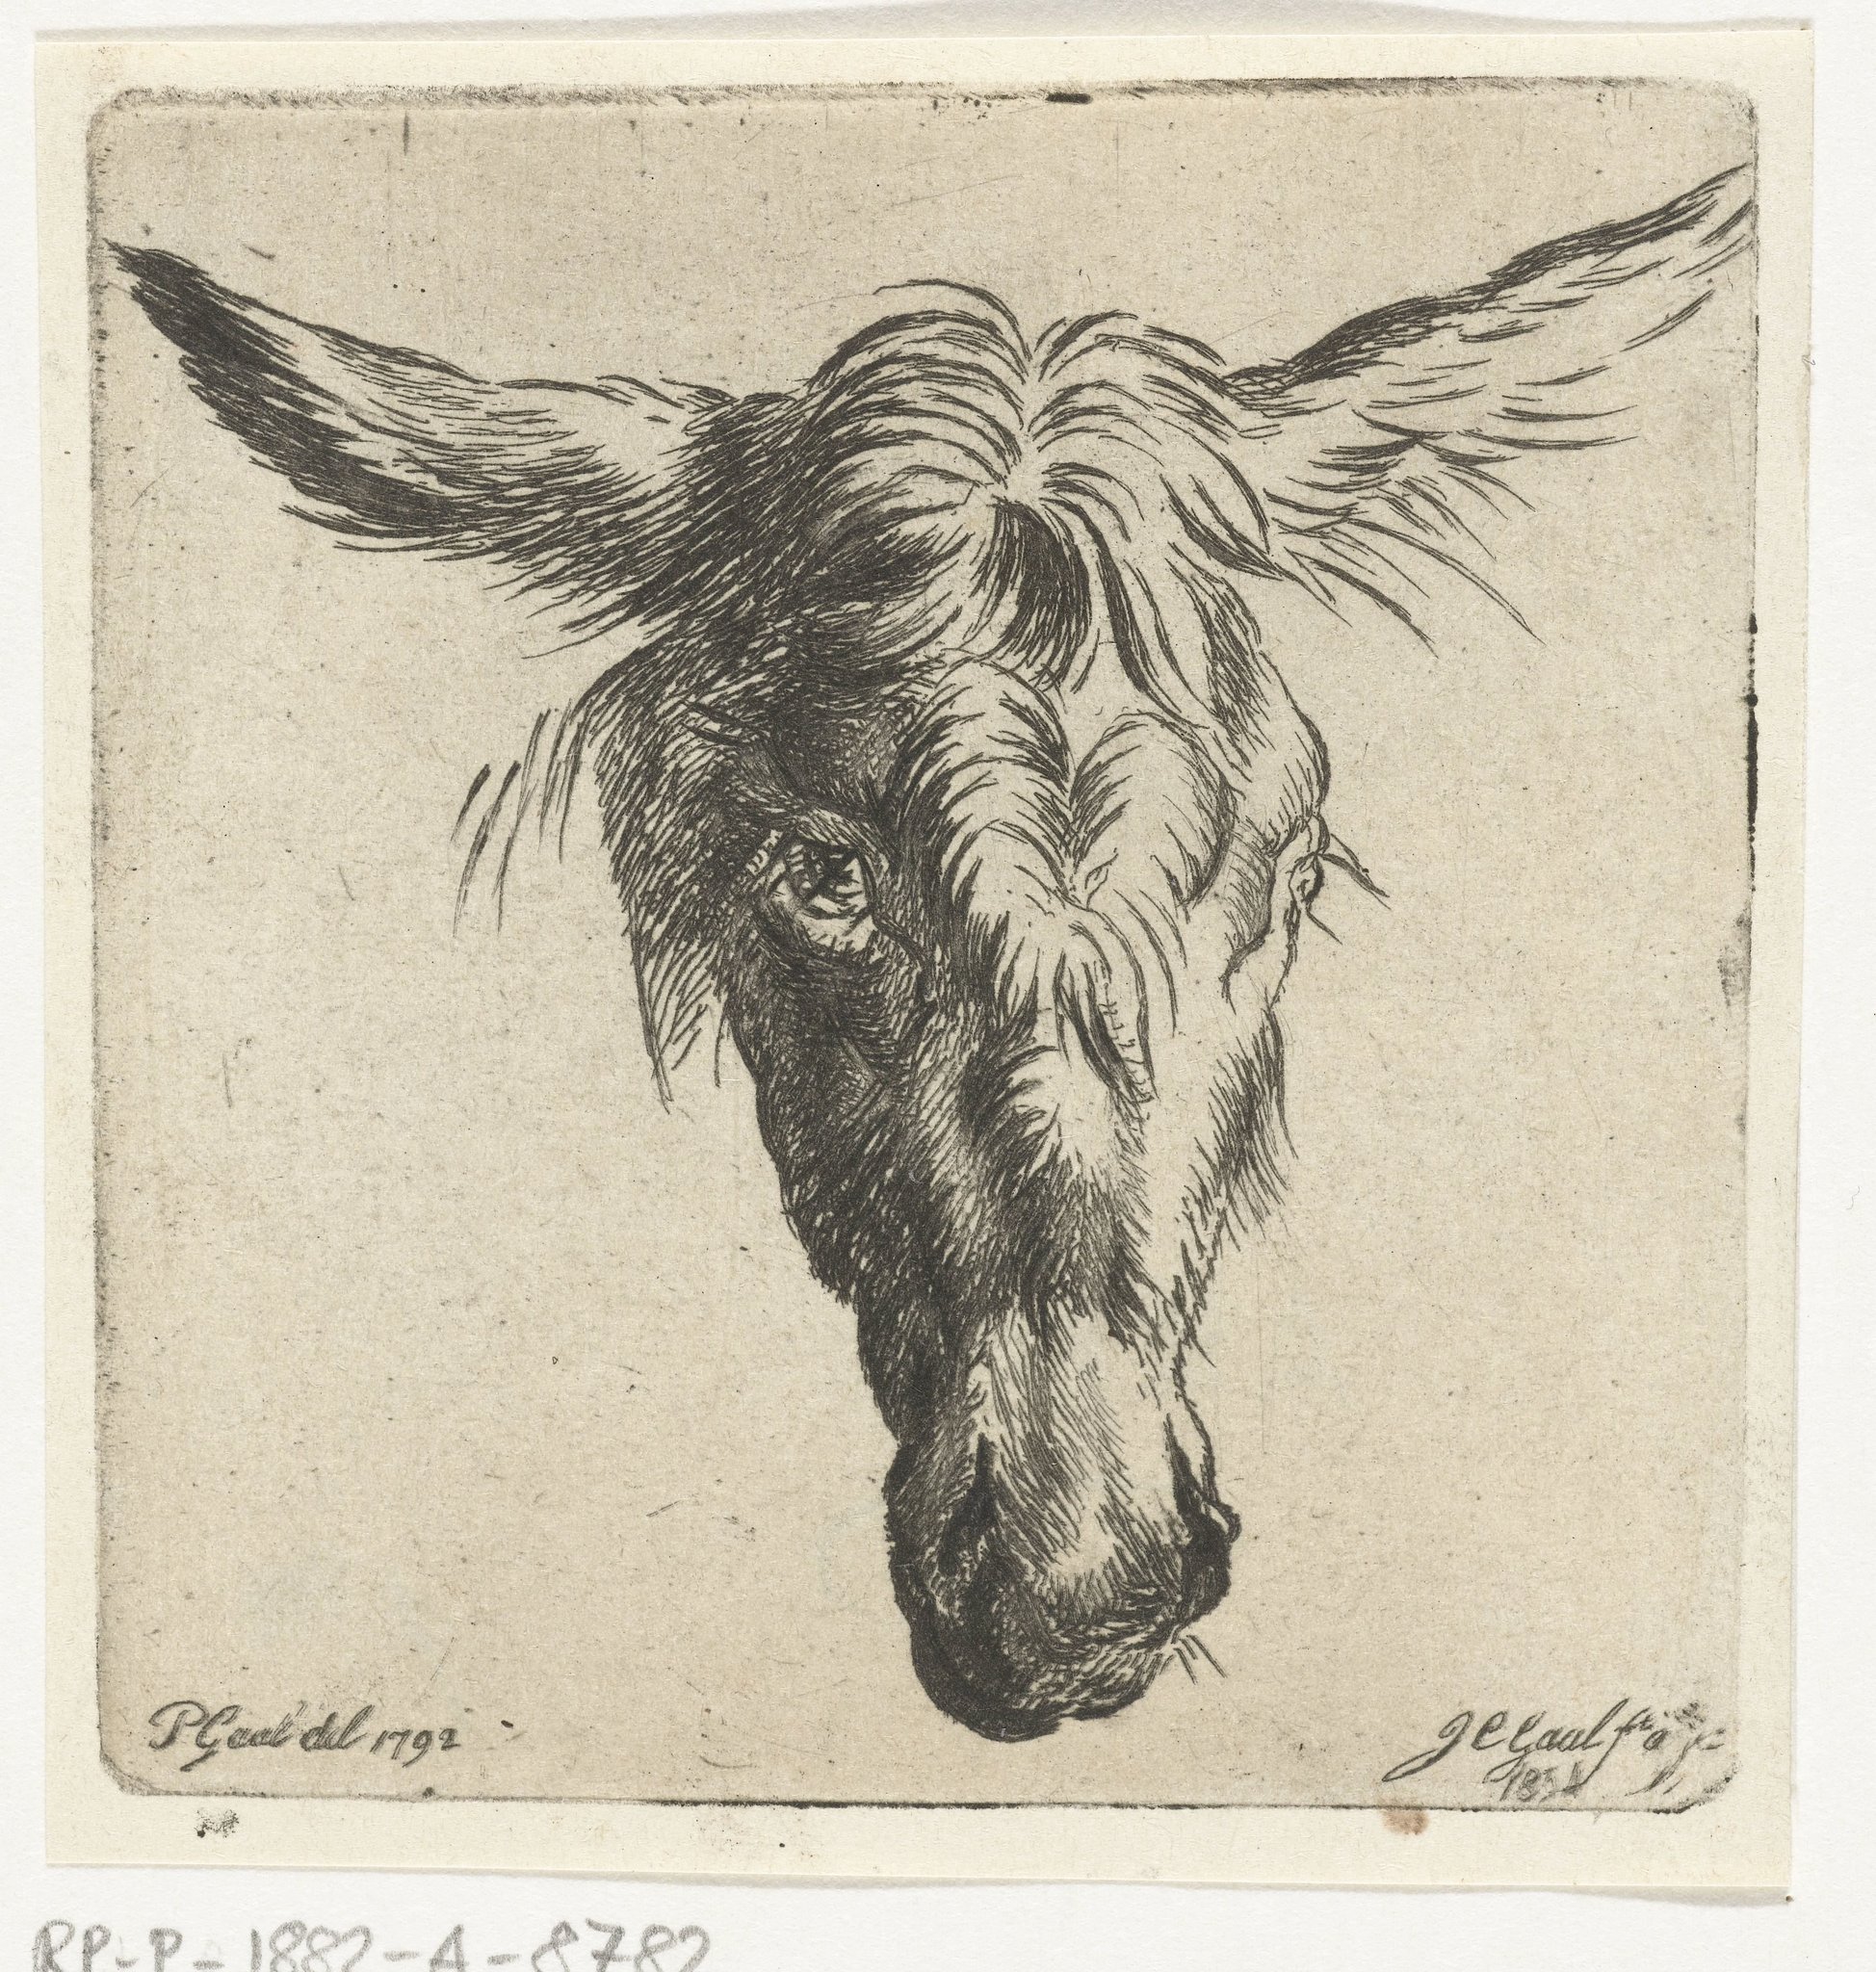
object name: print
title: Kop van een ezel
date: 1854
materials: paper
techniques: etching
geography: netherlands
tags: ass, donkey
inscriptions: collector's mark: Lugt 2228